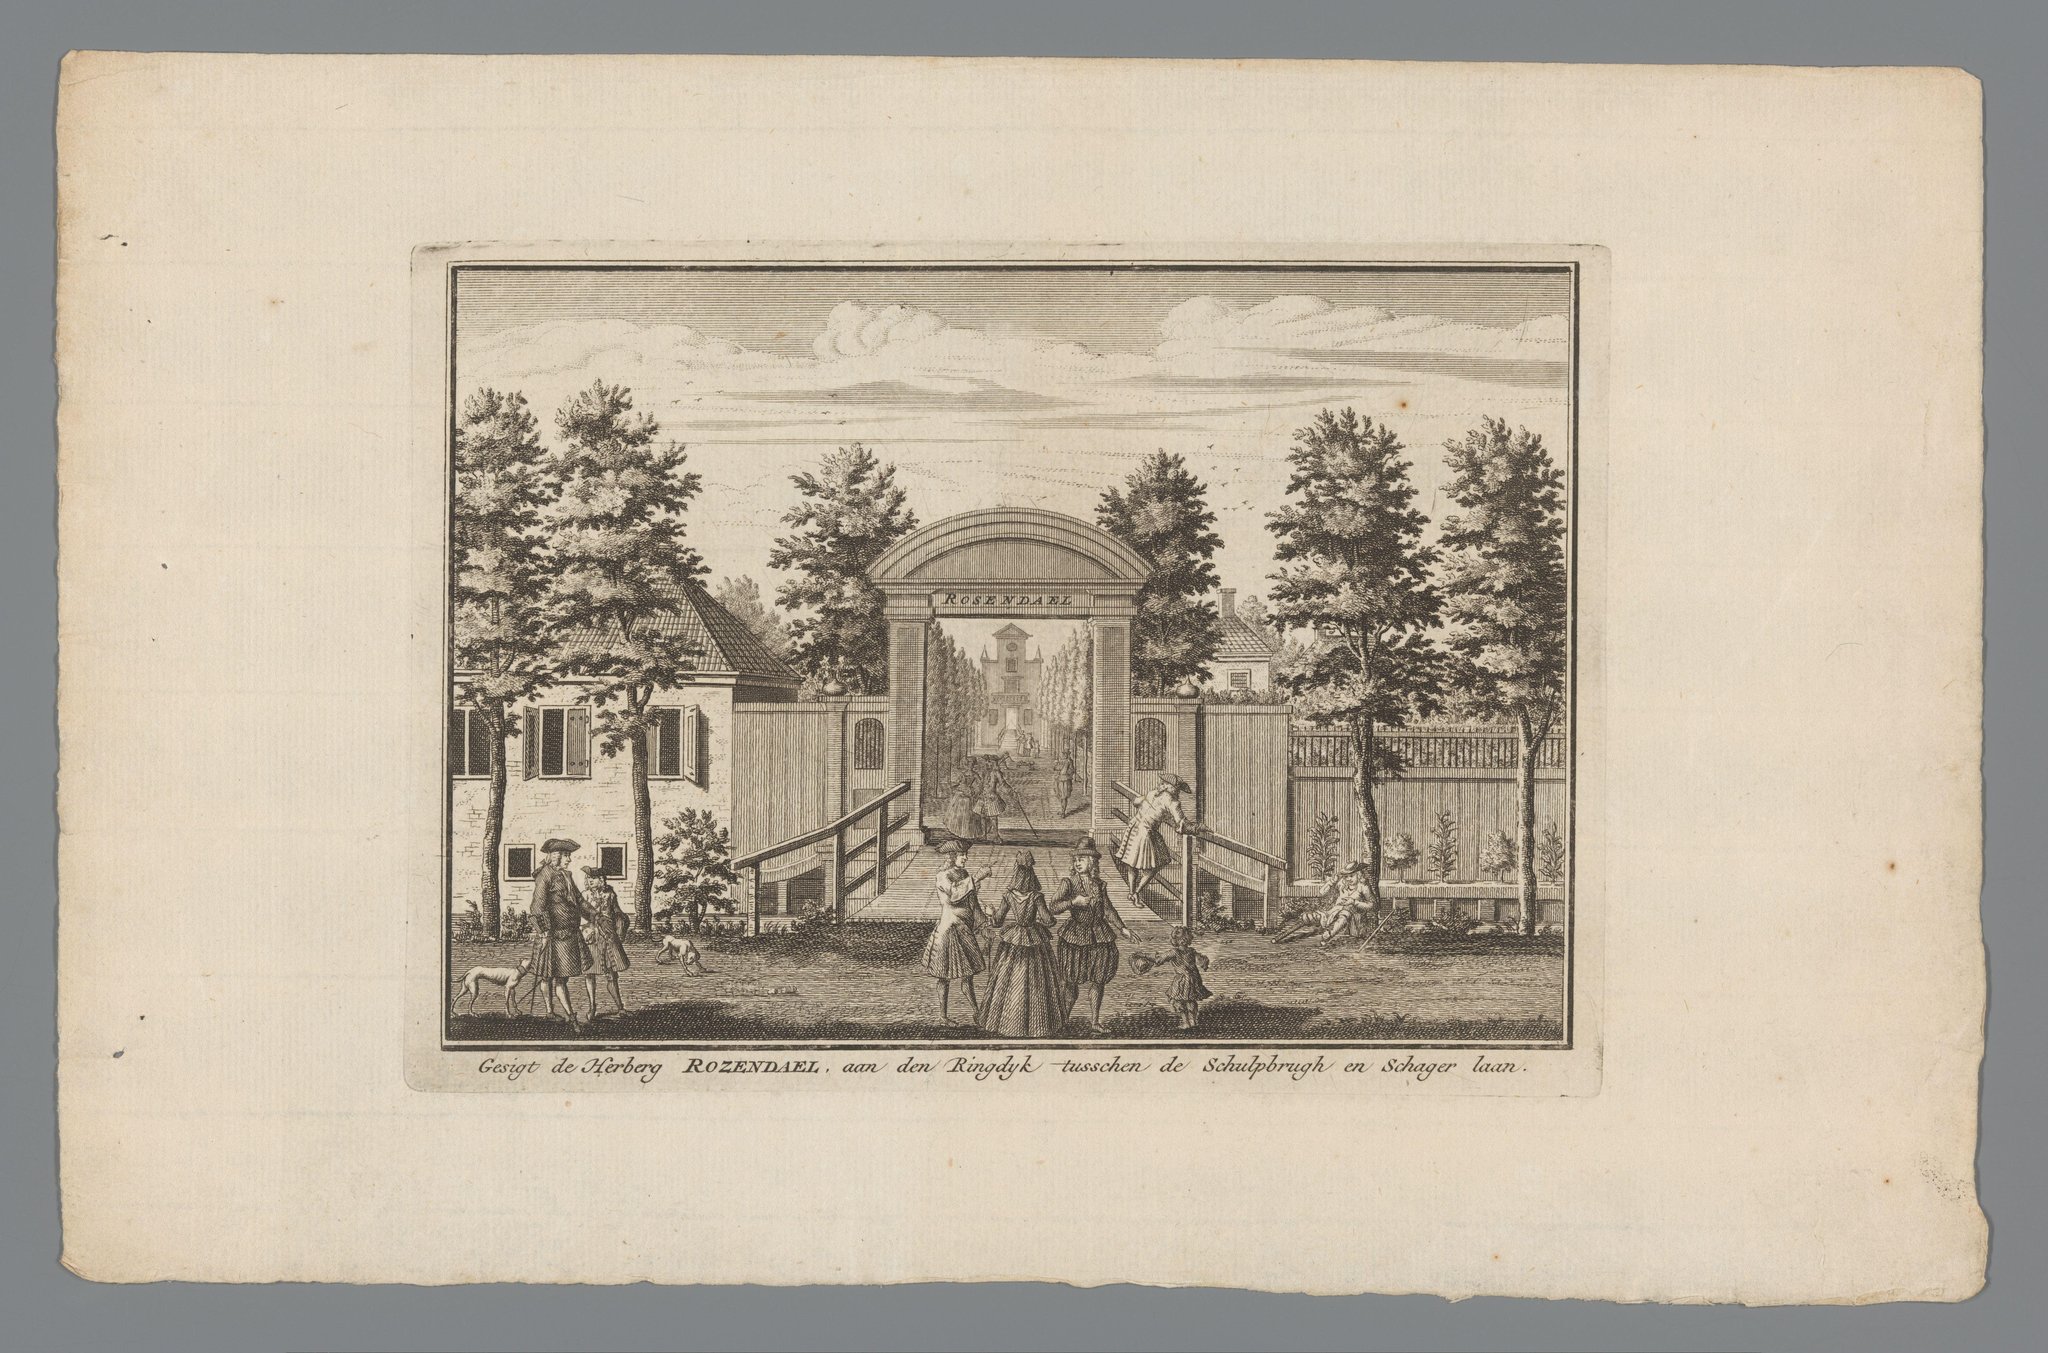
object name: print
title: Gesigt de Herberg Rozendael, aan den Ringdyk tusschen de Schulpbrugh en Schager laan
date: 1725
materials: paper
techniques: etching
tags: hotel, hostelry, inn